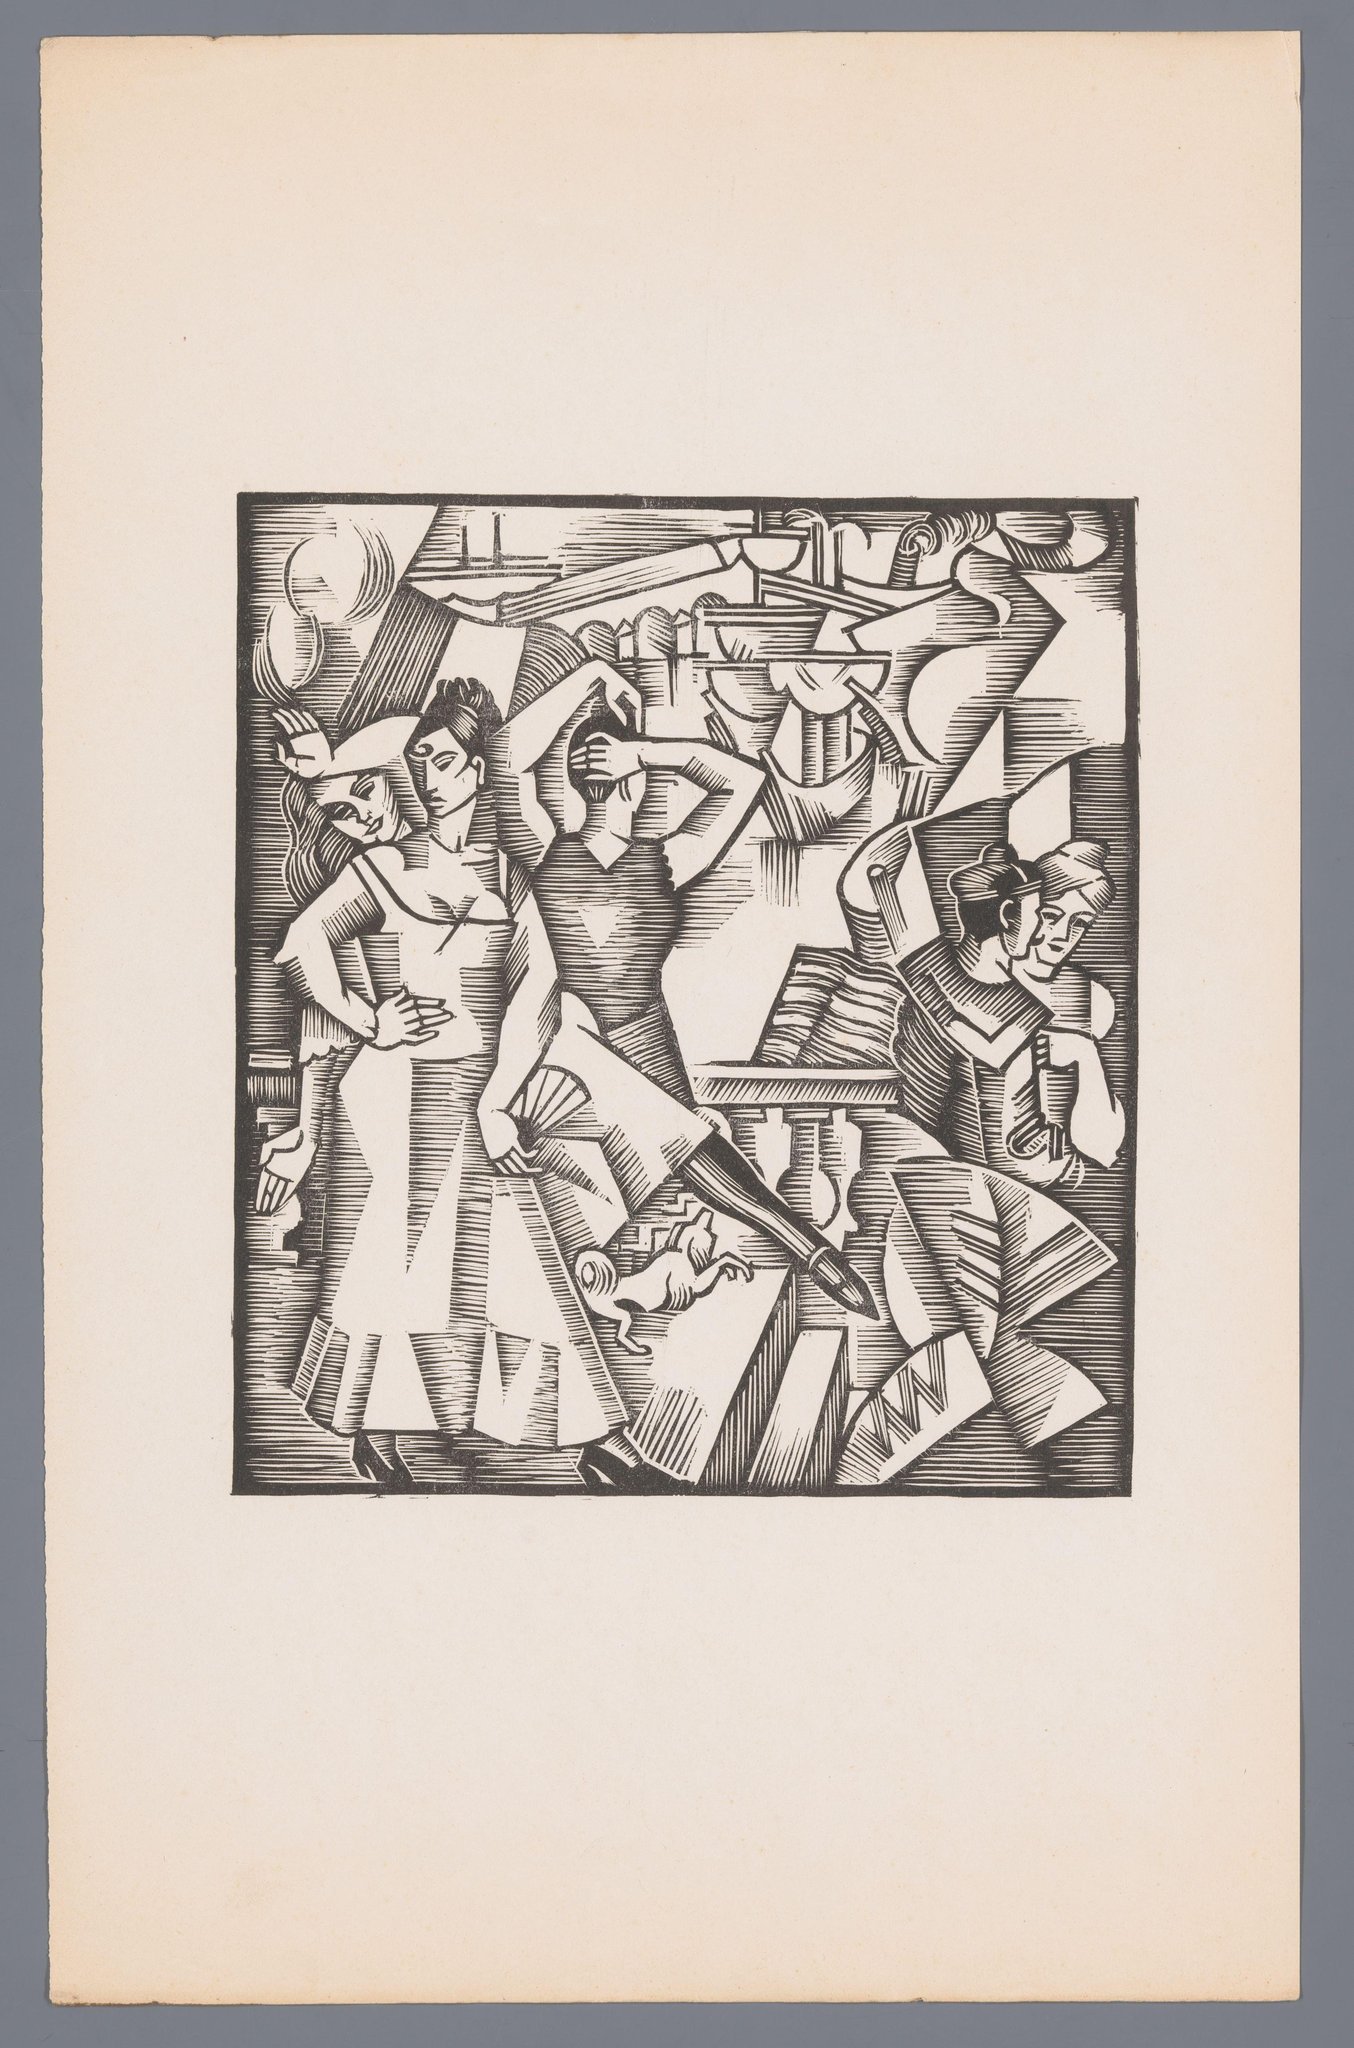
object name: print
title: Grand Largue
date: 1925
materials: paper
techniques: woodcut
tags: dancing, inn, coffee-house, public house, etc., sailor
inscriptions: collector's mark: Lugt 2228, collector's mark: Lugt 2760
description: Deze prent bevindt zich in een omslag en maakt deel uit van een zesdelige serie prenten met als onderwerp de zee en het leven van zeemannen, gemaakt door André Lhote.